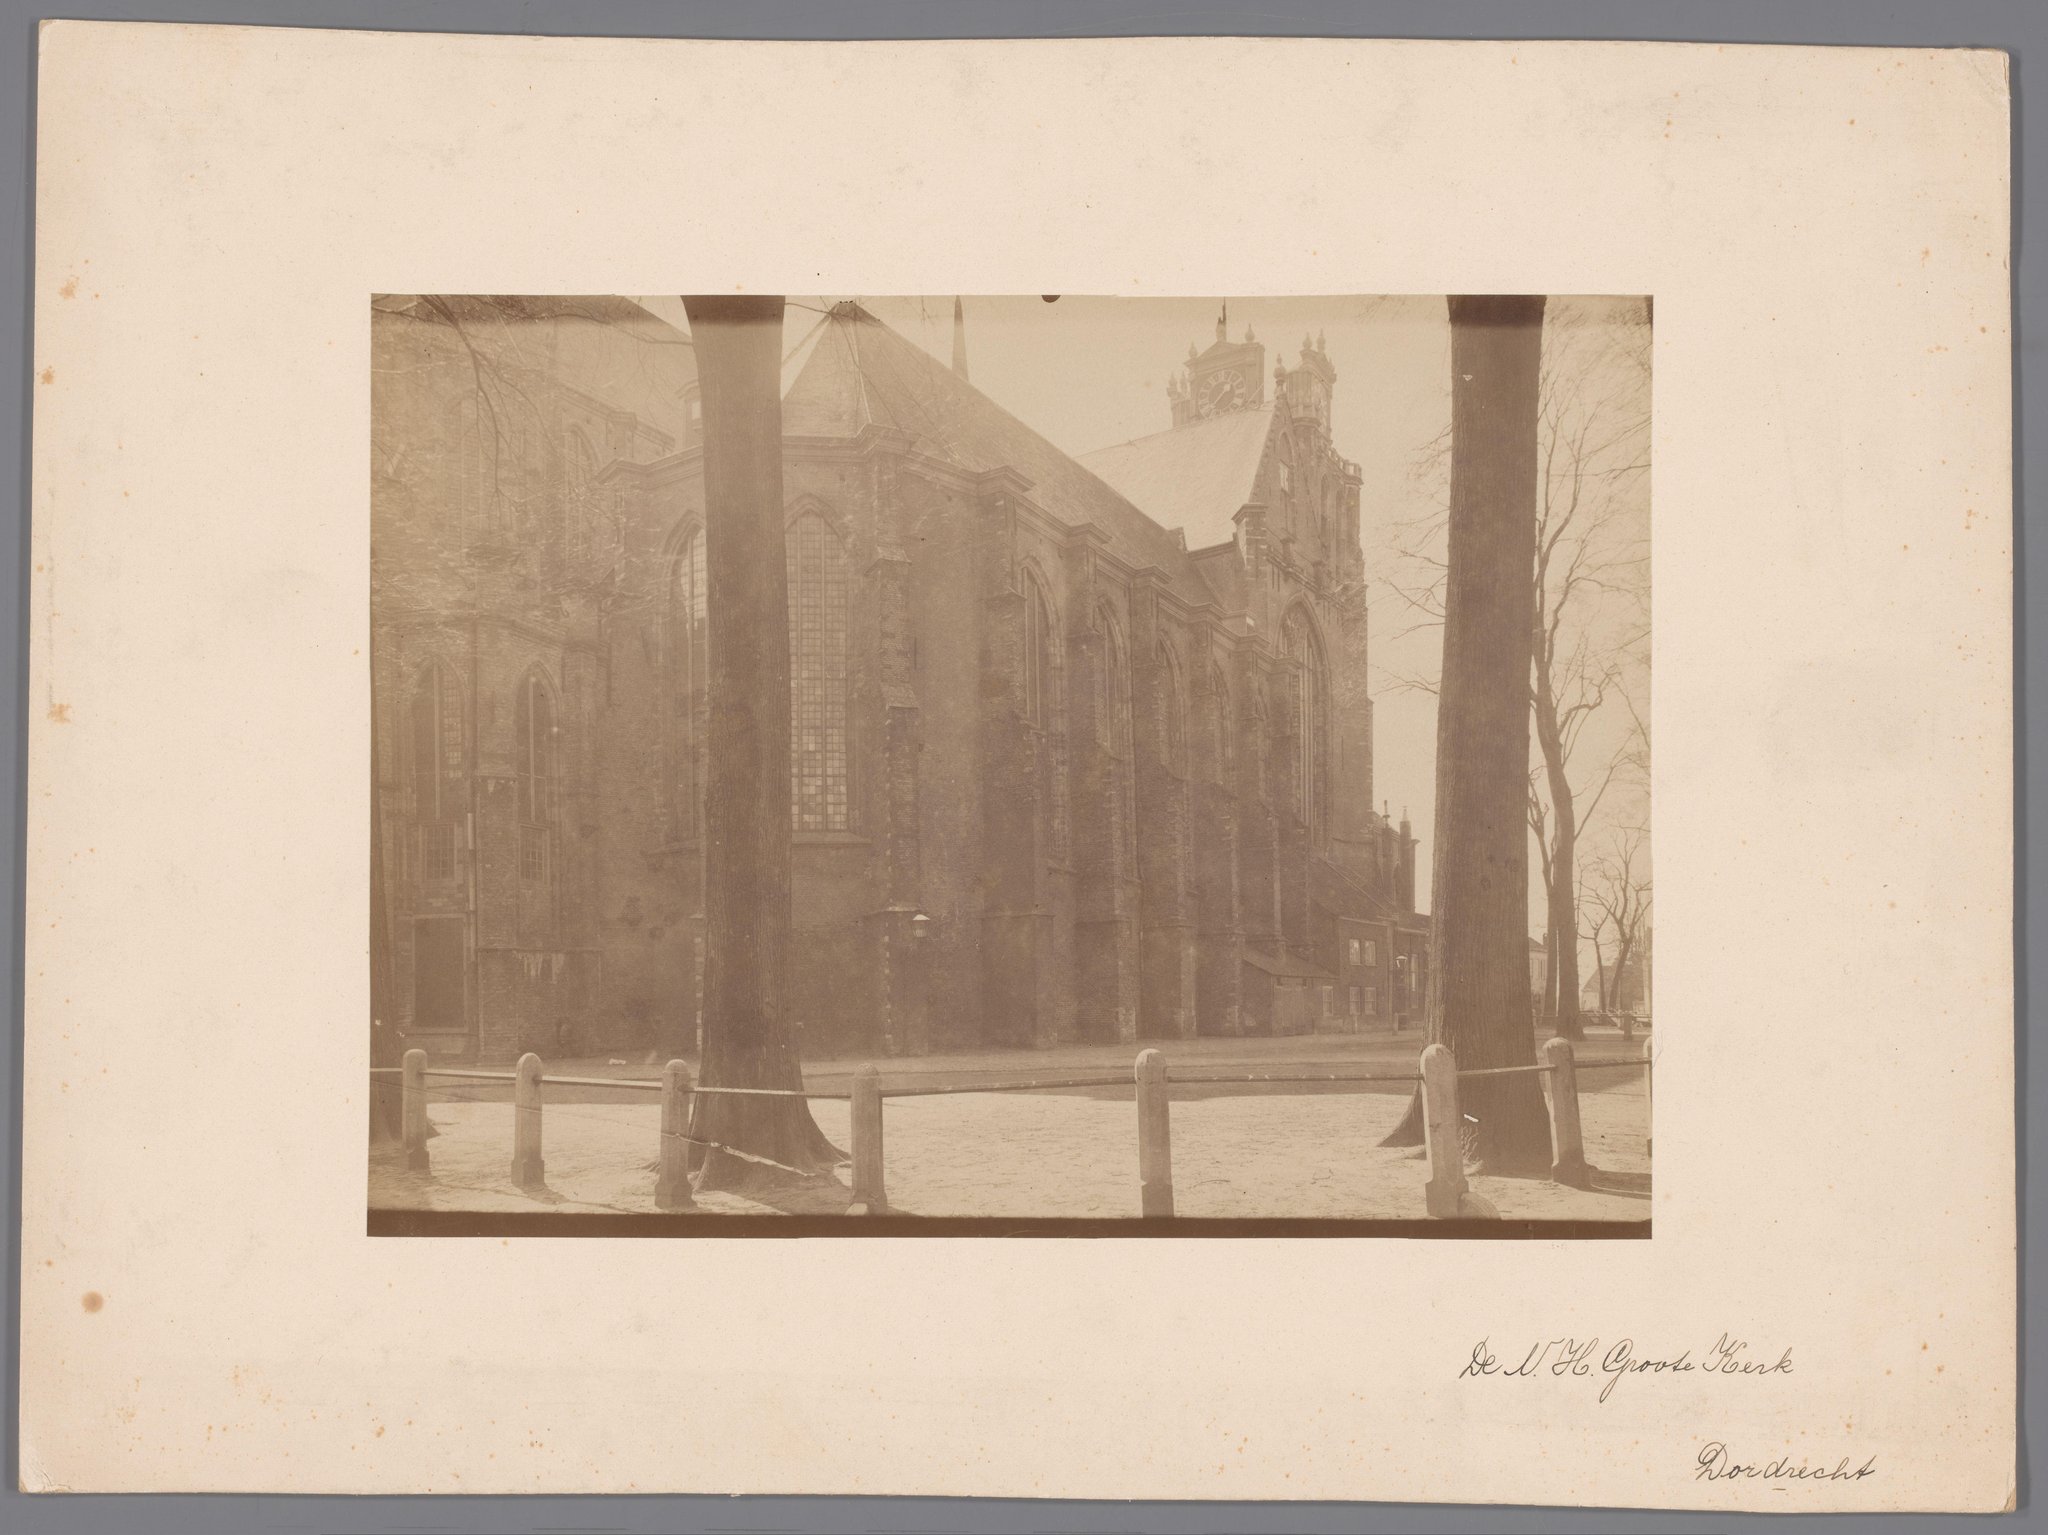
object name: photograph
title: Gezicht op de Grote of Onze-Lieve-Vrouwenkerk te Dordrecht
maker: anoniem (monumentenzorg)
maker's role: fotograaf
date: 1880-1910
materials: cardboard, photographic support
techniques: albumen print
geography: grotekerksplein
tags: church (exterior)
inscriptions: annotation: ‘De N.H. Groote Kerk/ Dordrecht’, annotation: ‘Dordrecht (Z.H.)/ groote kerk’